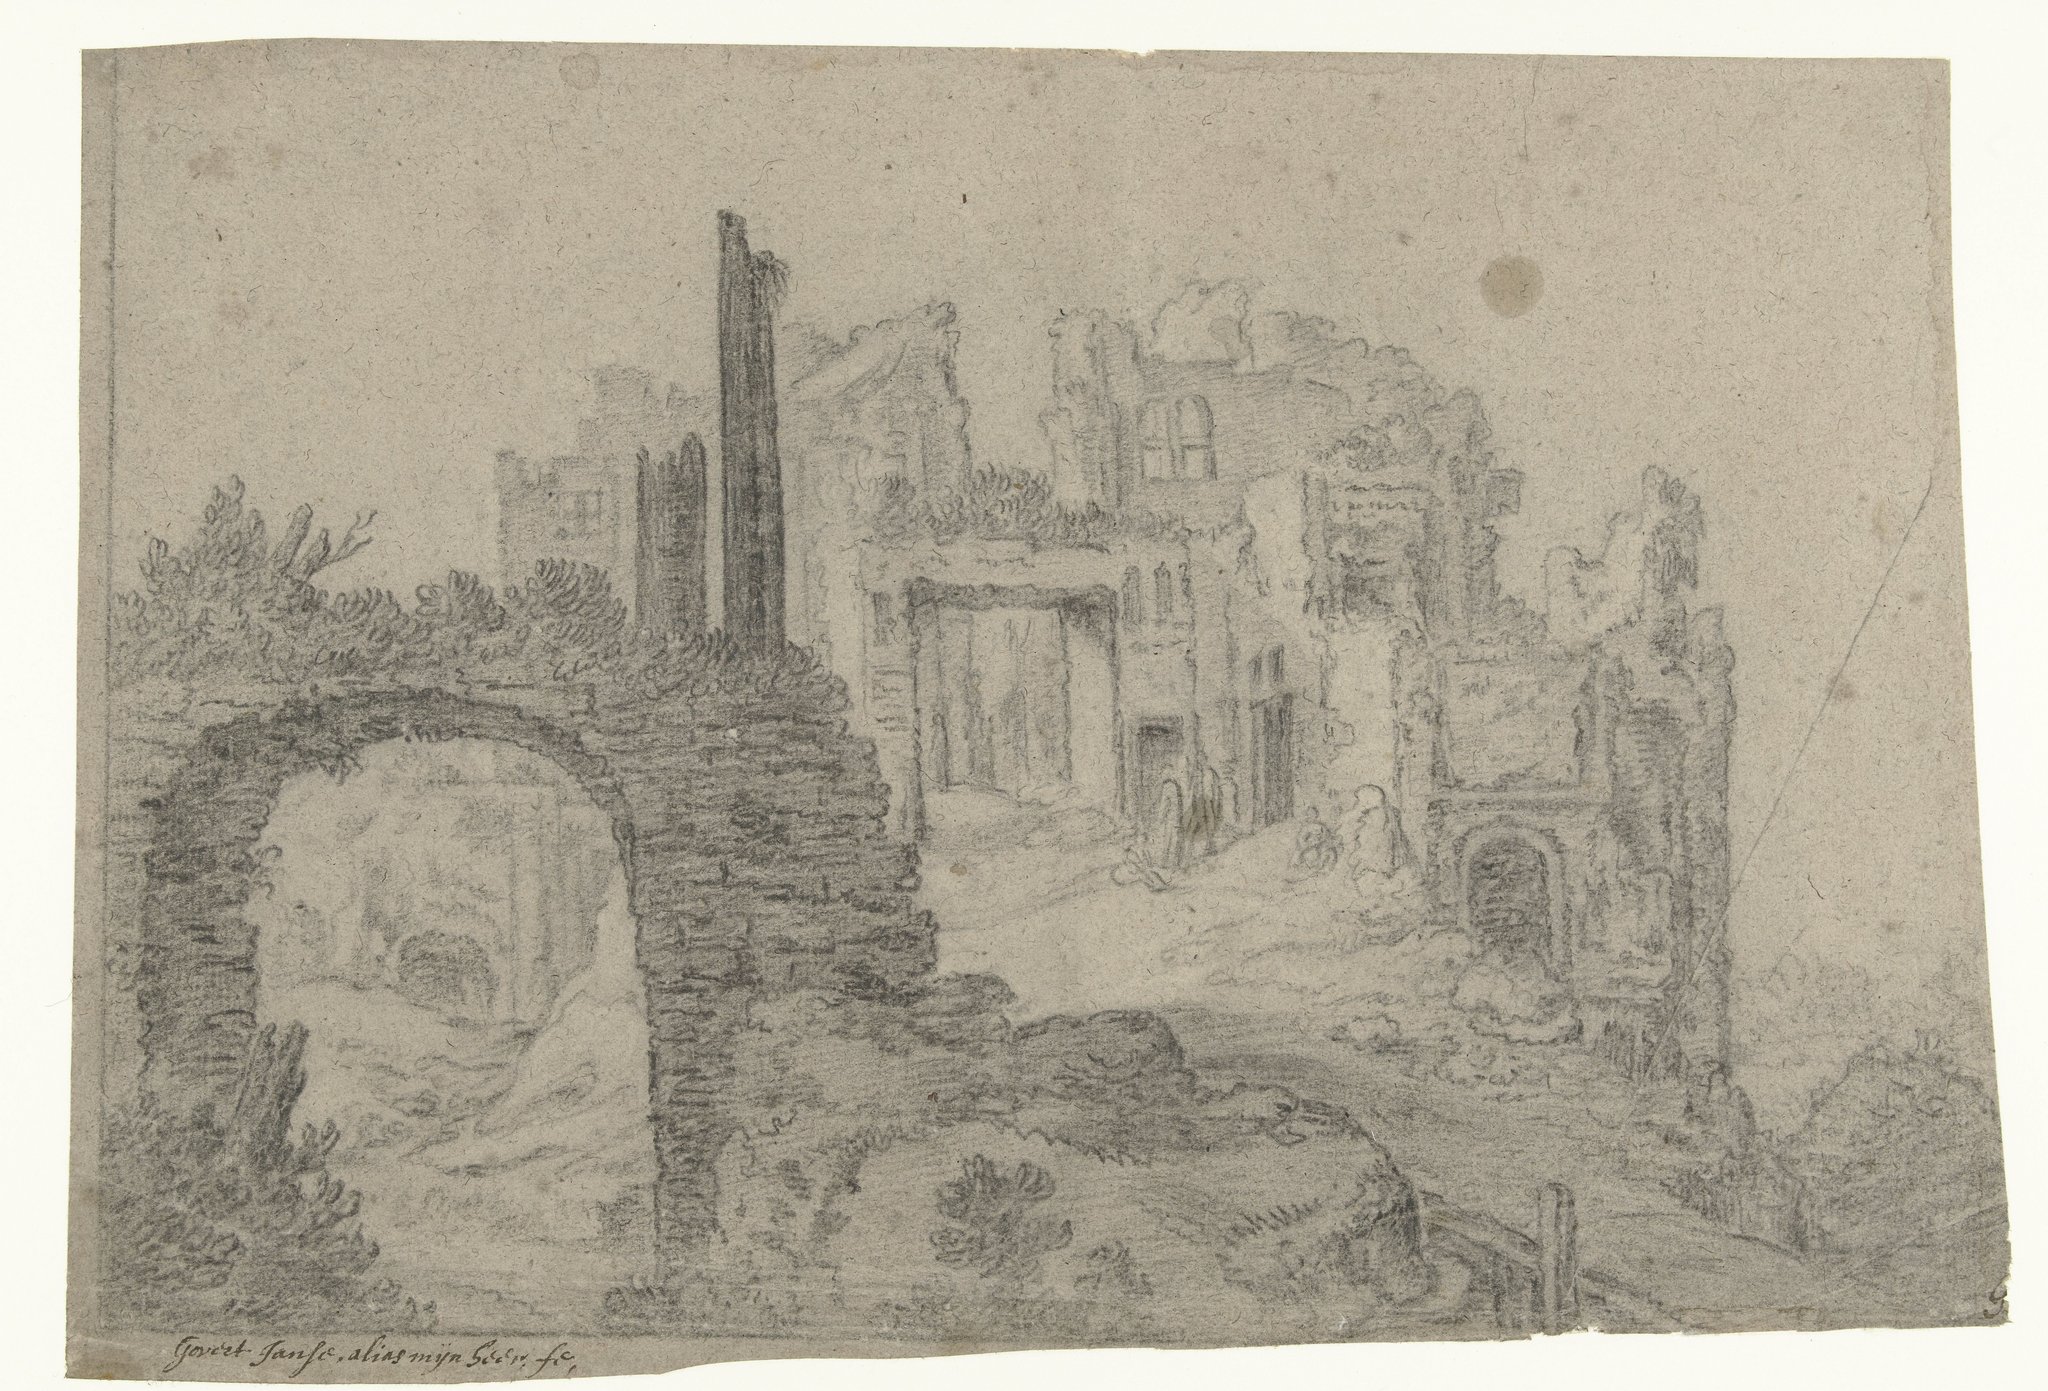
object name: drawing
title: Bouwval op een heuvel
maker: govert jansz. genaamd mijnheer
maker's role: draughtsman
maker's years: 1578-1619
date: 1588-1619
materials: paper, chalk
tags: ruin of a building ~ architecture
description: Bouwval op een heuvel; links op de voorgrond de begroeide resten van een poort.